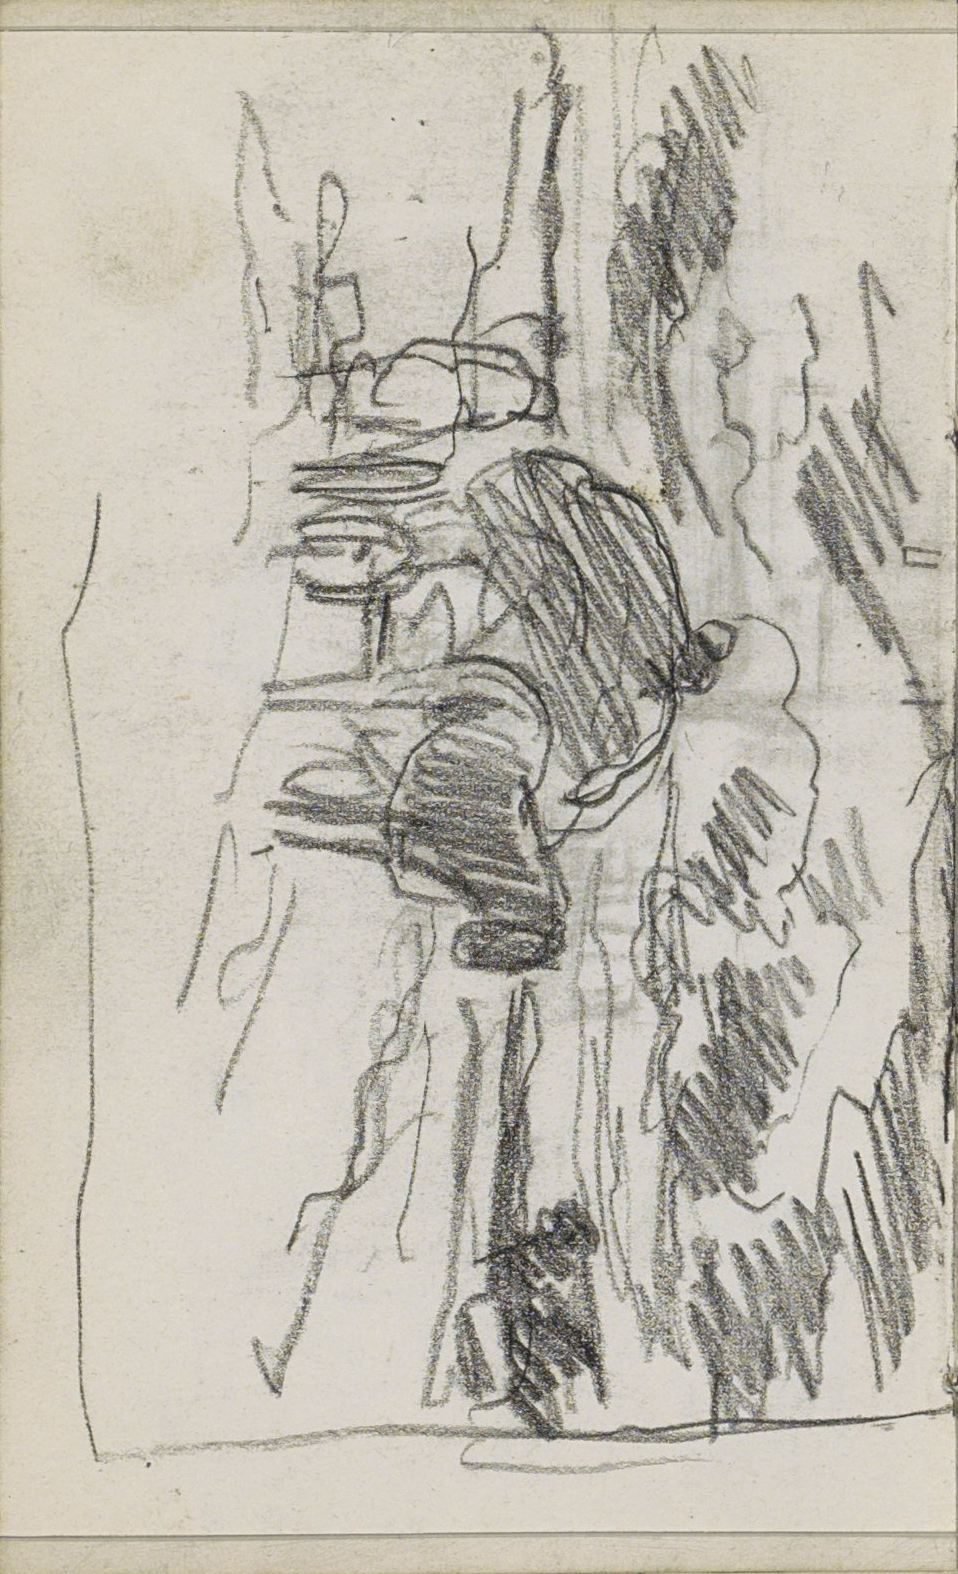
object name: sketchbook leaf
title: Paard en wagen in een landschap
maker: anton mauve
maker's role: draughtsman, painter, print maker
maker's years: 1838-1888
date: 1848-1888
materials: chalk, paper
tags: animal traction, animal-drawn vehicle (carriage etc.)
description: Blad 36 verso uit een schetsboek met 53 bladen.